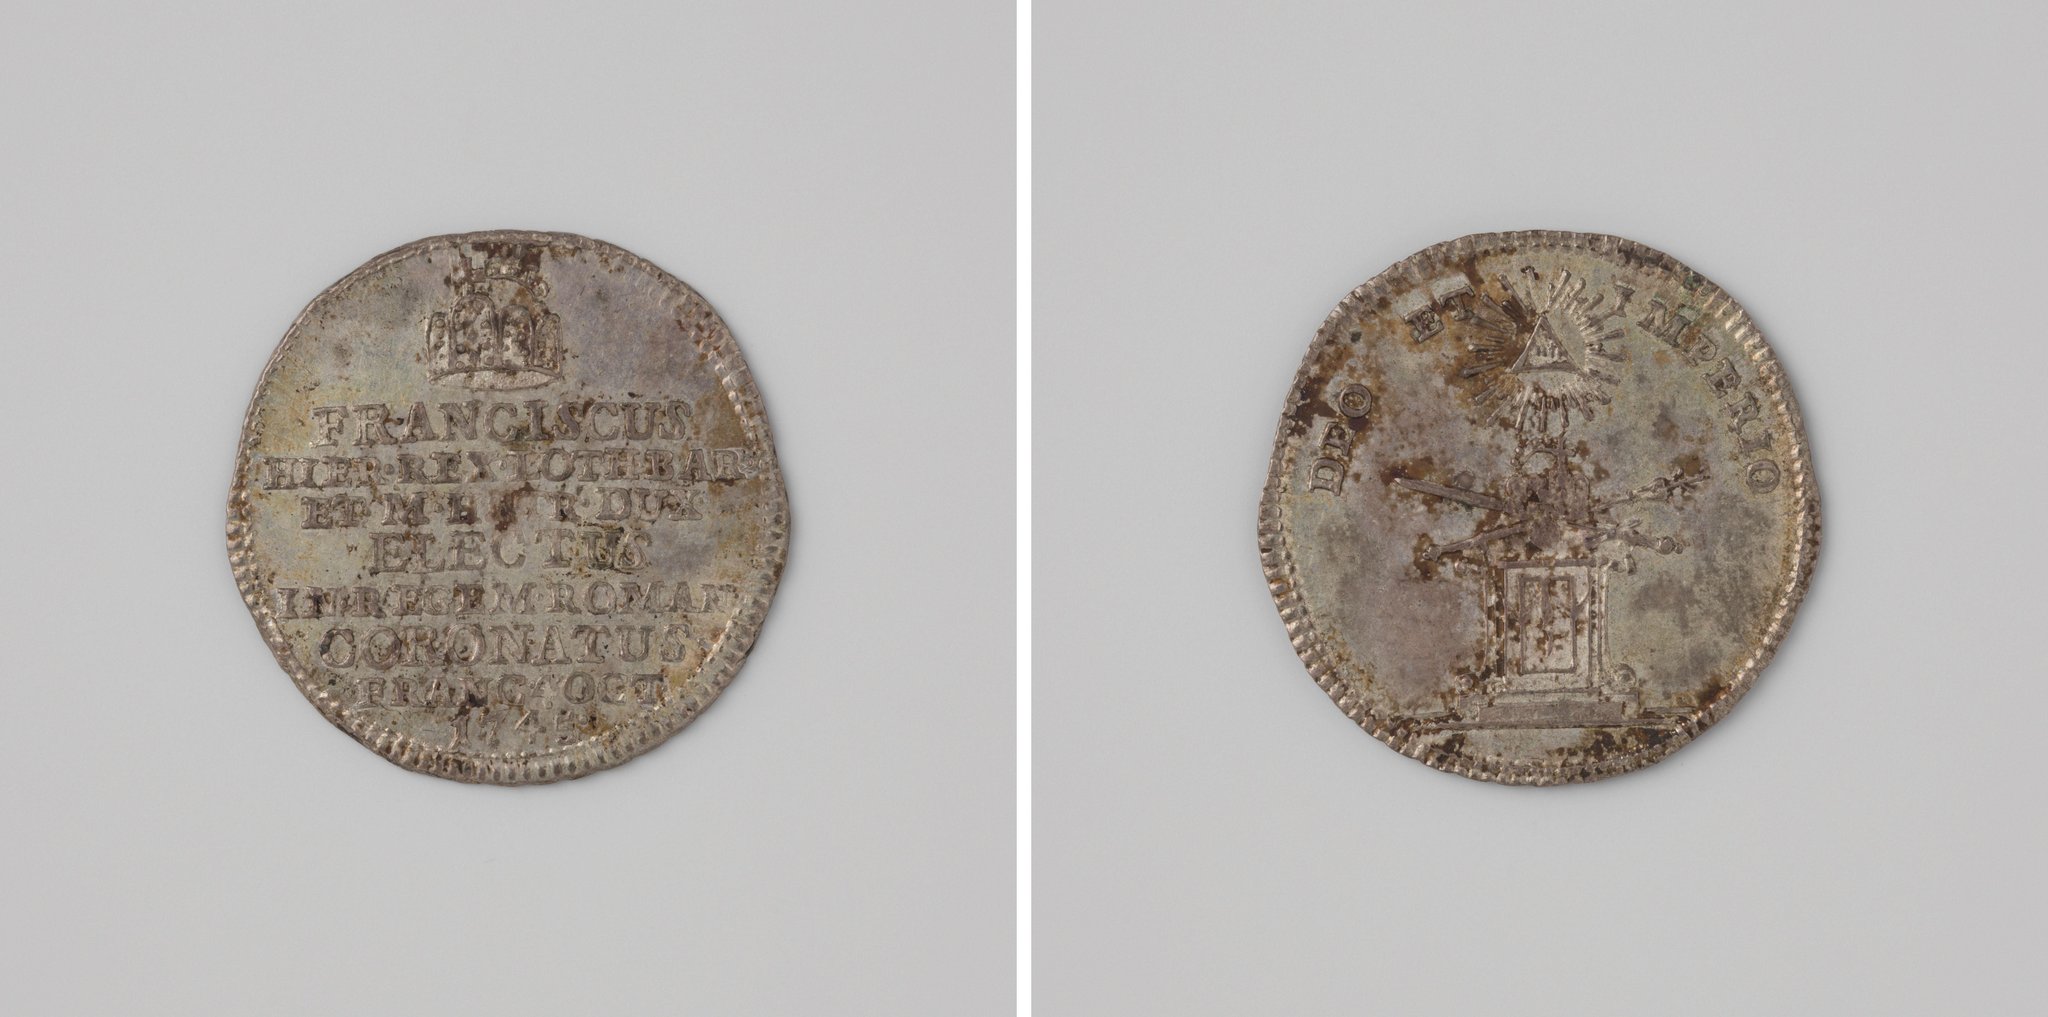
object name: strooipenning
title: Kroning van Frans I tot Duits keizer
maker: Anonymous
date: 1745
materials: silver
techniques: striking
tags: frans i stefan (duits keizer)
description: Zilveren penning. Voorzijde: opschrift onder kroon. Keerzijde: kroon, scepter, zwaard en rijksappel op altaar beschenen door stralende driehoek binnen omschrift